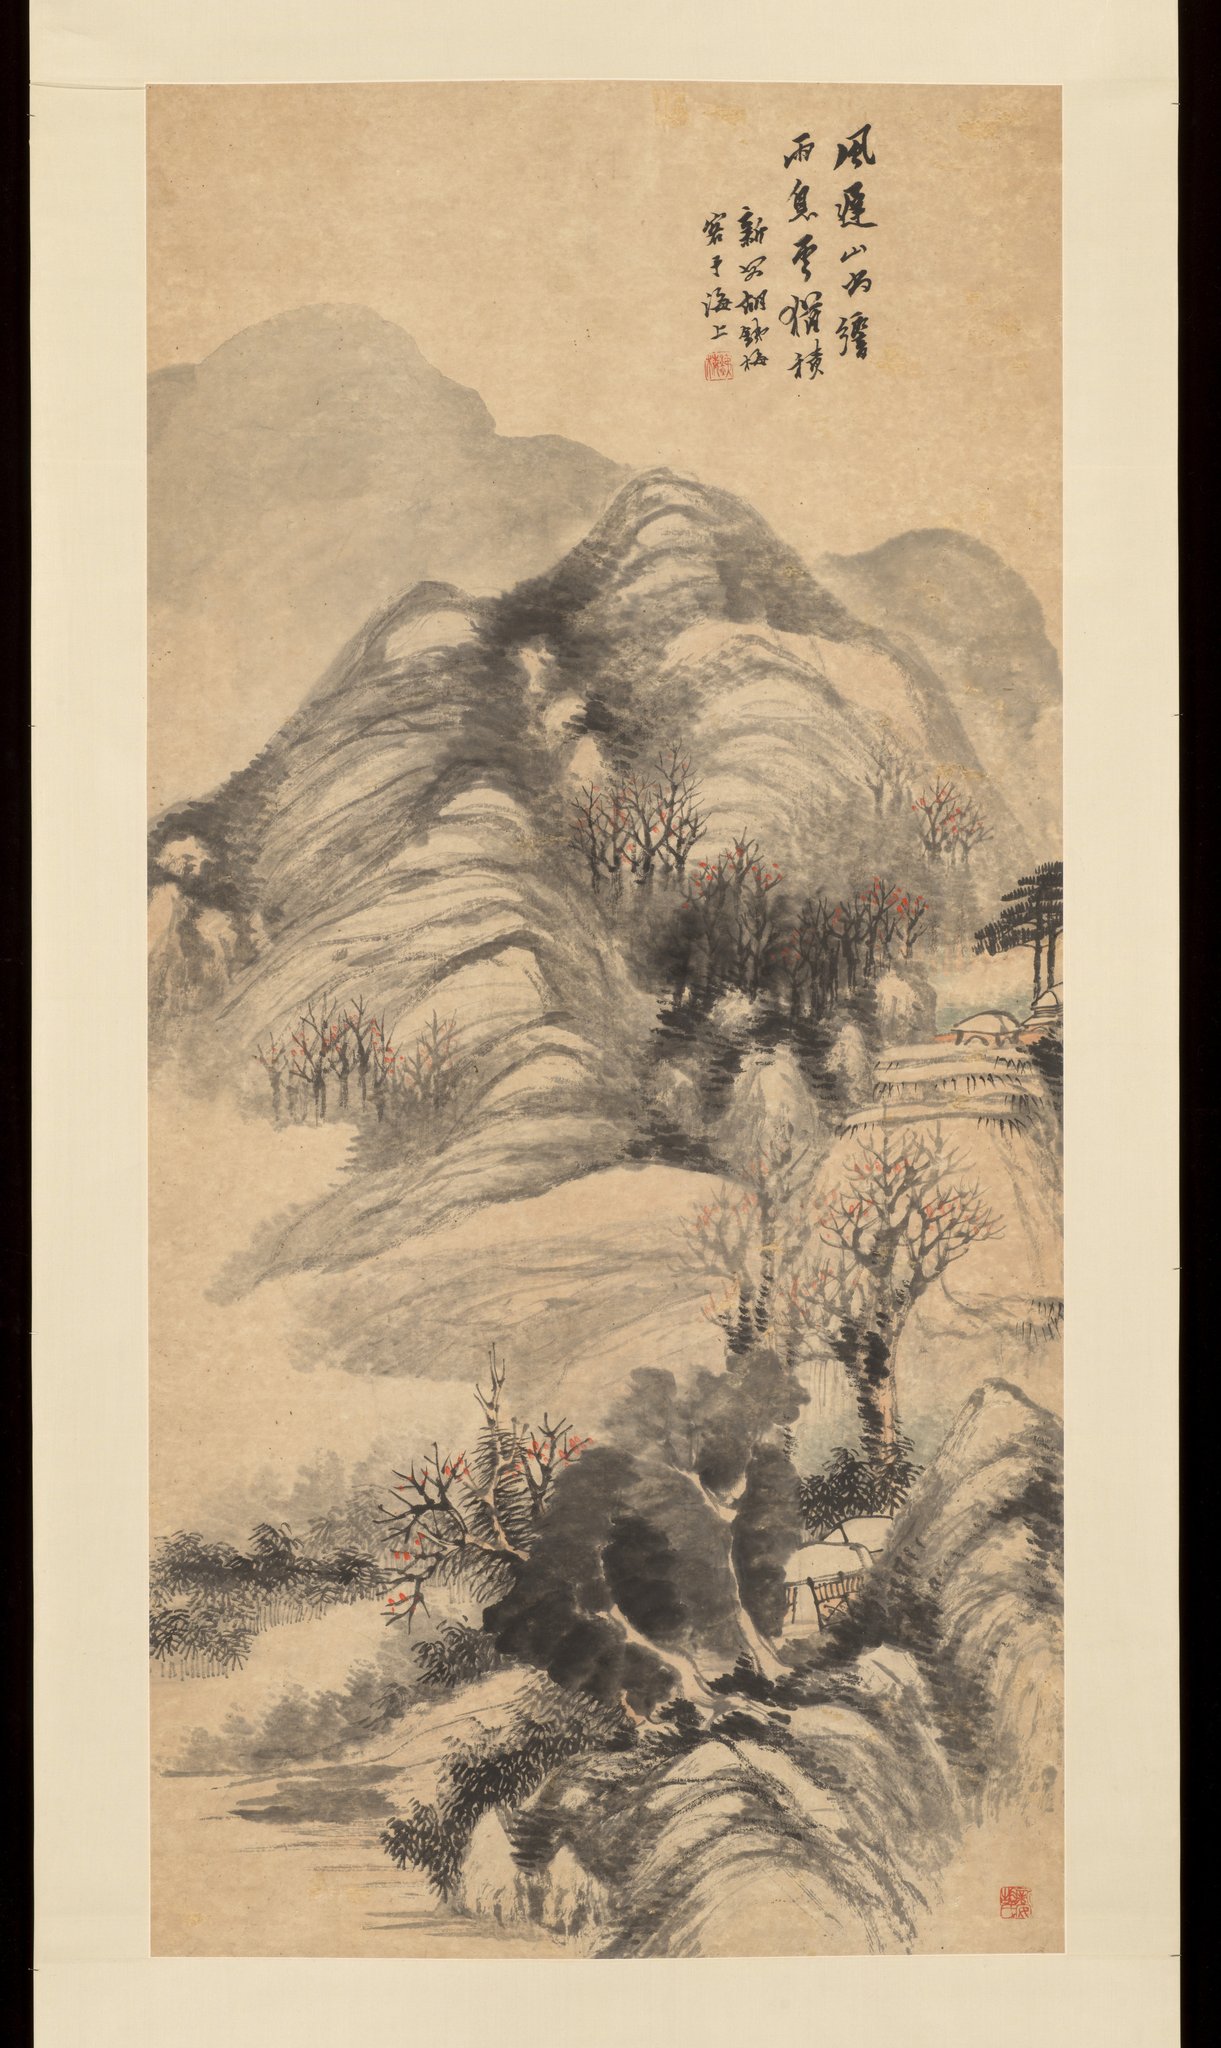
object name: hanging scroll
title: Landscape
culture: chinese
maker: hu zhang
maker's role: artist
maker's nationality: chinese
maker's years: 1848-1899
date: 1848-1899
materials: ink, paper